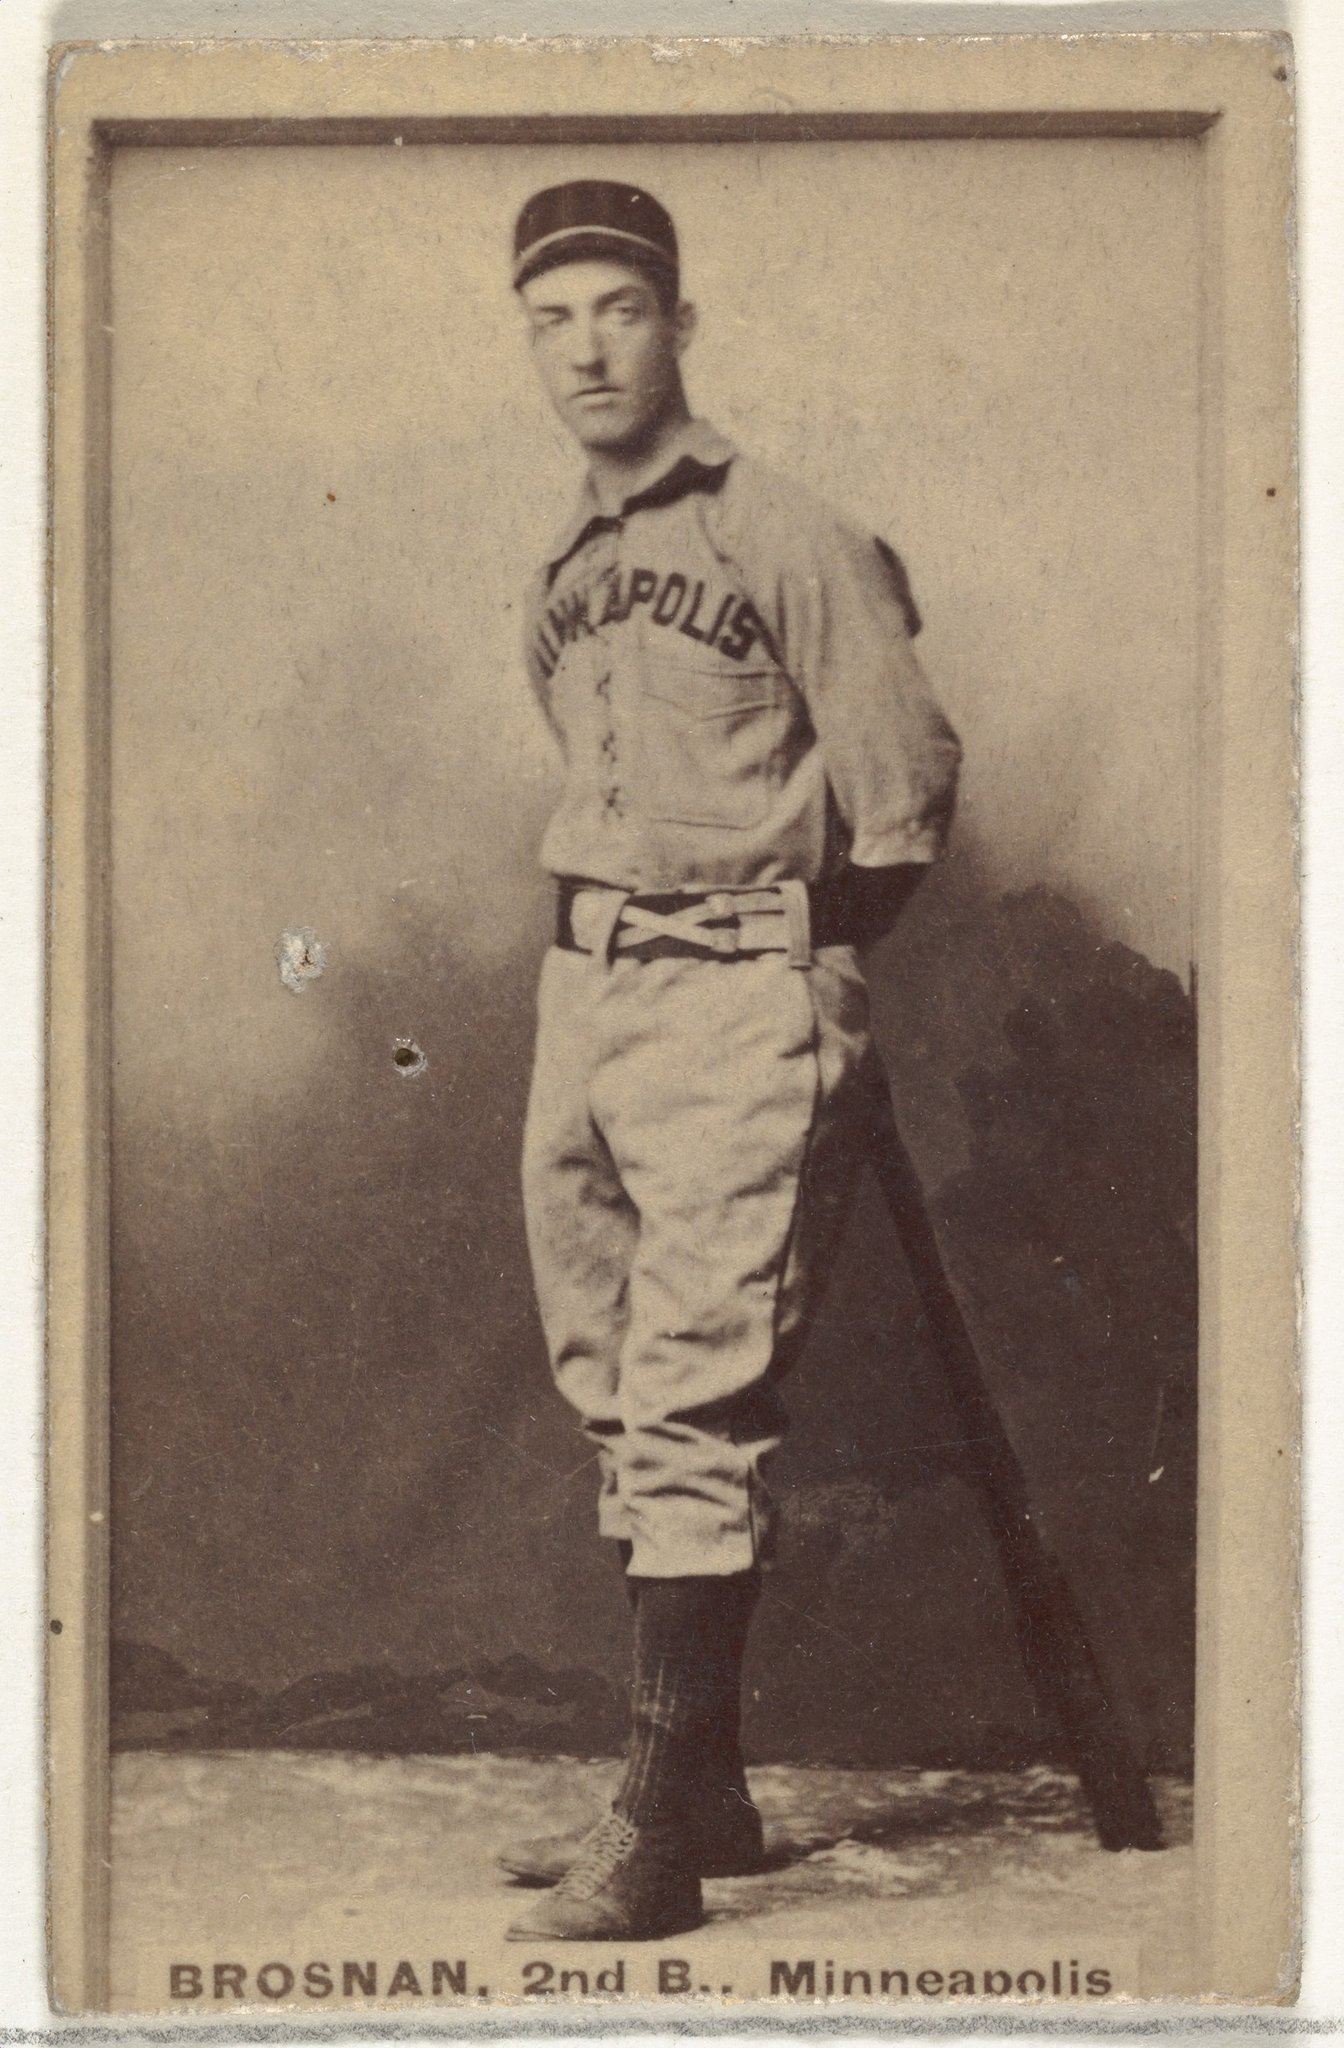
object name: baseball card, photograph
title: Timothy J. Brosnan, 2nd Base, Minneapolis, from the Old Judge series (N172) for Old Judge Cigarettes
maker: goodwin & company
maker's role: publisher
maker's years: 1850-1950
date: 1887-1890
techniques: albumen silver print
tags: men,portraits,baseball,athletes